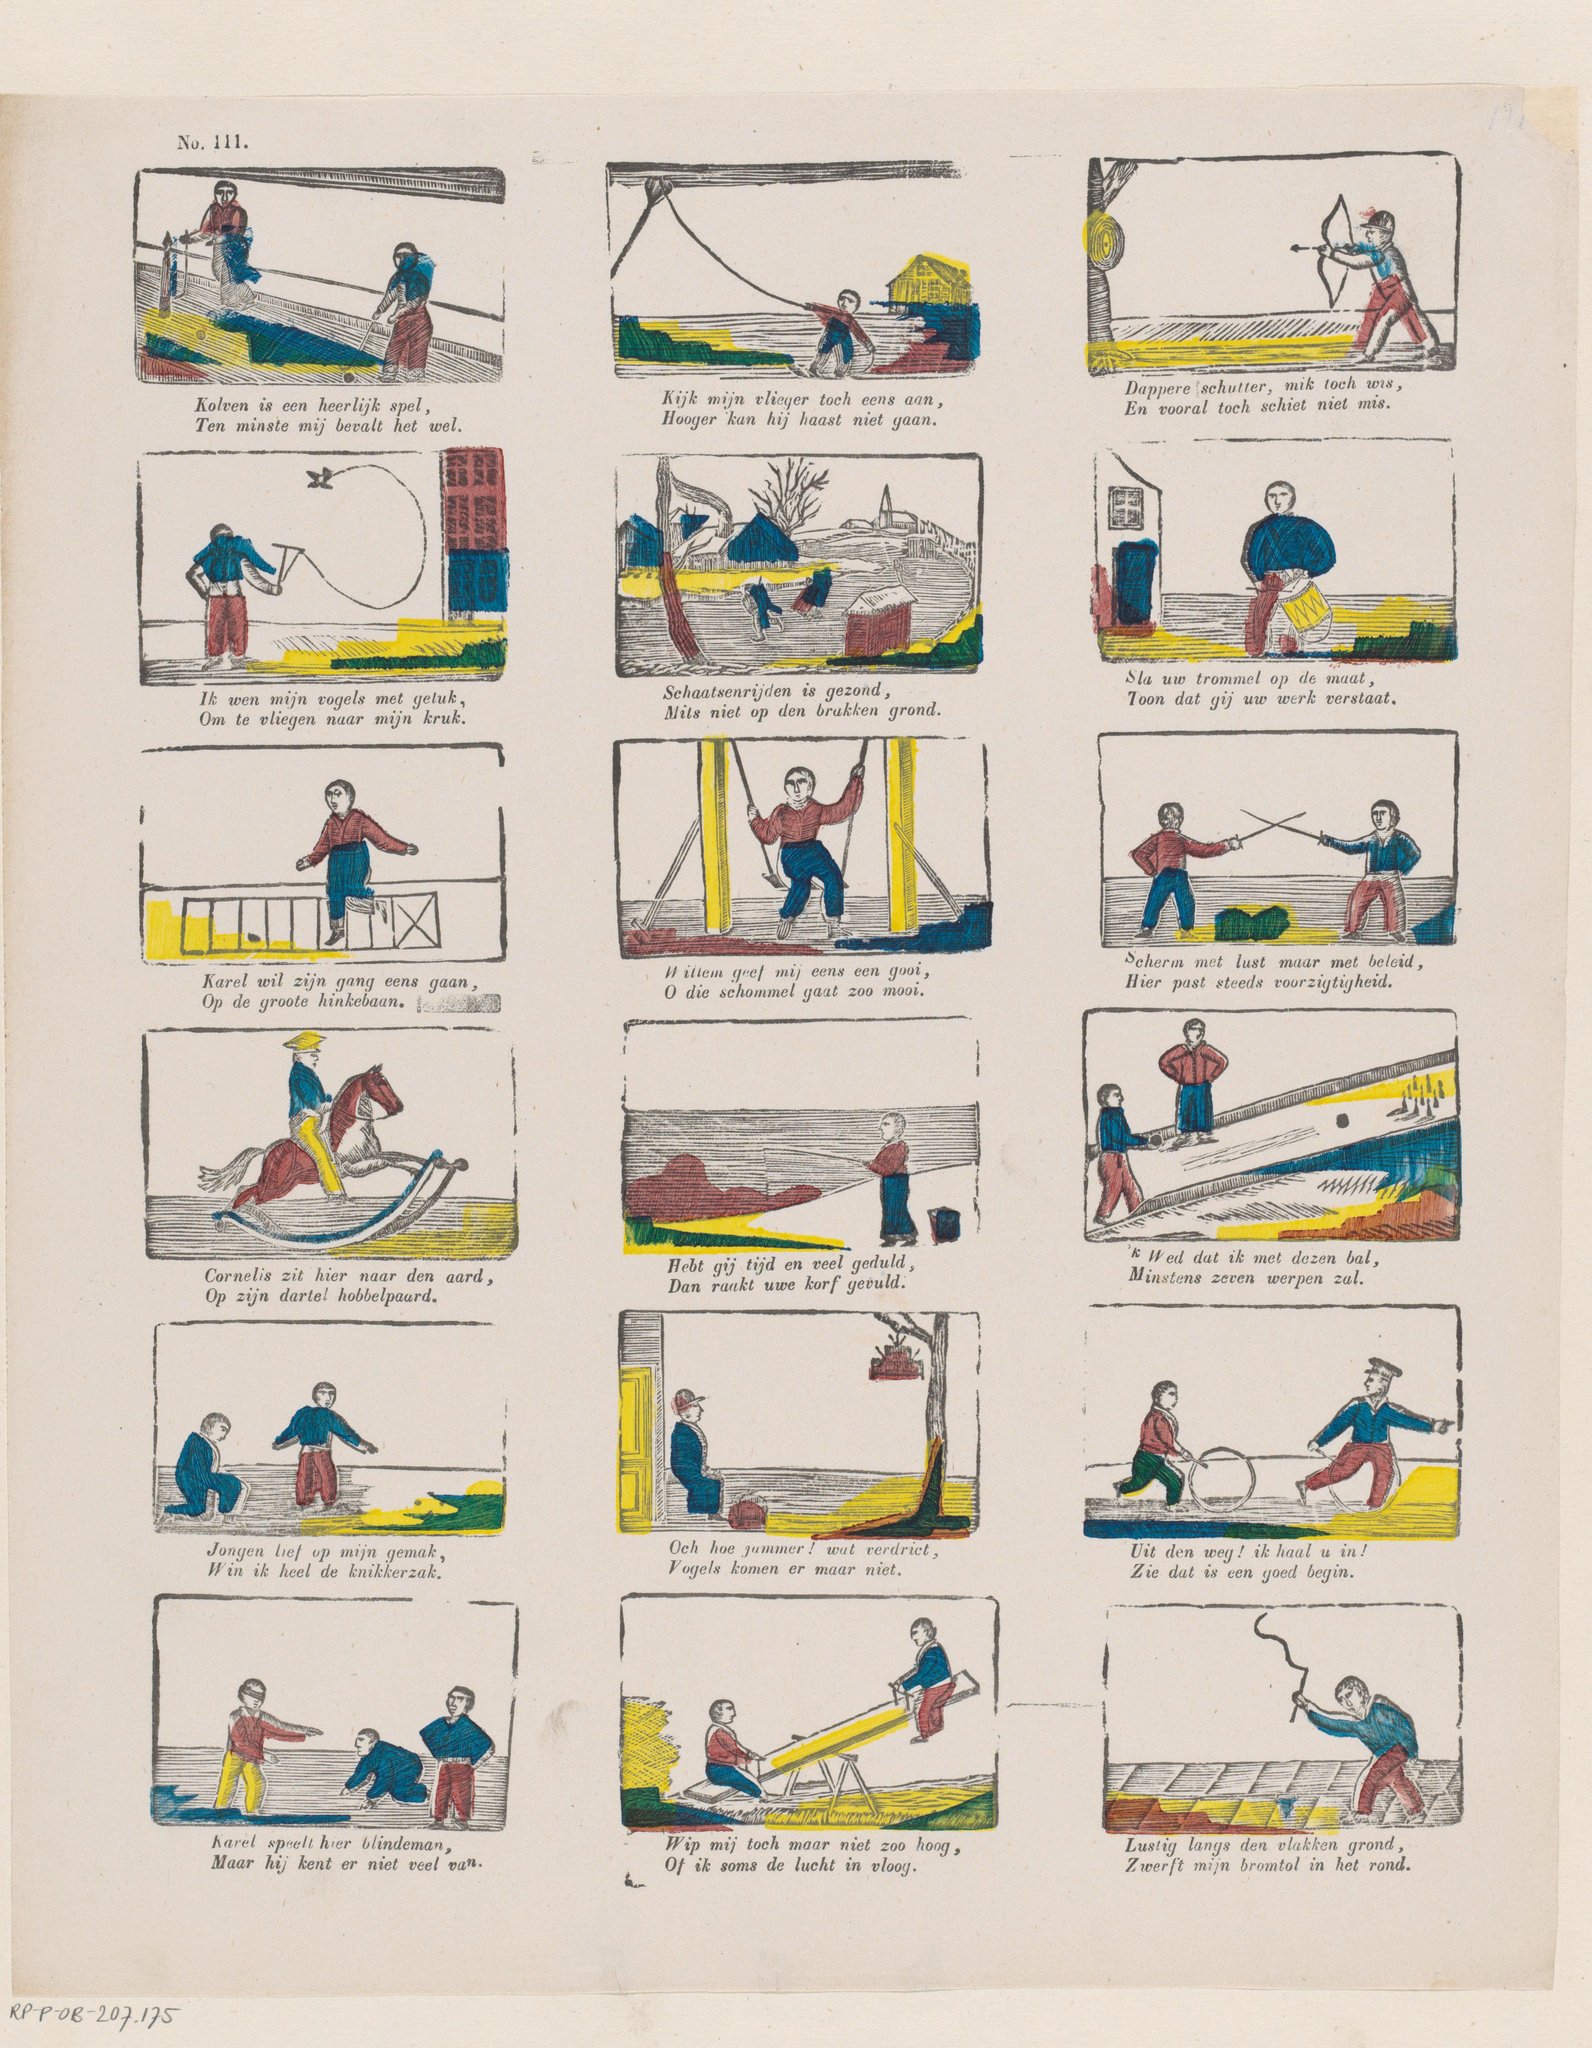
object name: popular print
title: Kinderspelen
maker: Anonymous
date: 1848-1881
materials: paper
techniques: colour, letterpress printing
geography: den bosch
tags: children's games and plays, blind-man's buff, (flying a) kite, games using special objects (marbles, top, hoop, etc.), seesaw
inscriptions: collector's mark: Lugt 2760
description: Blad met 18 voorstellingen van kinderspelen, zoals vliegeren, trommelen, hinkelen en hoepelen. Onder elke voorstelling een tweeregelig vers. Genummerd linksboven: No 111.